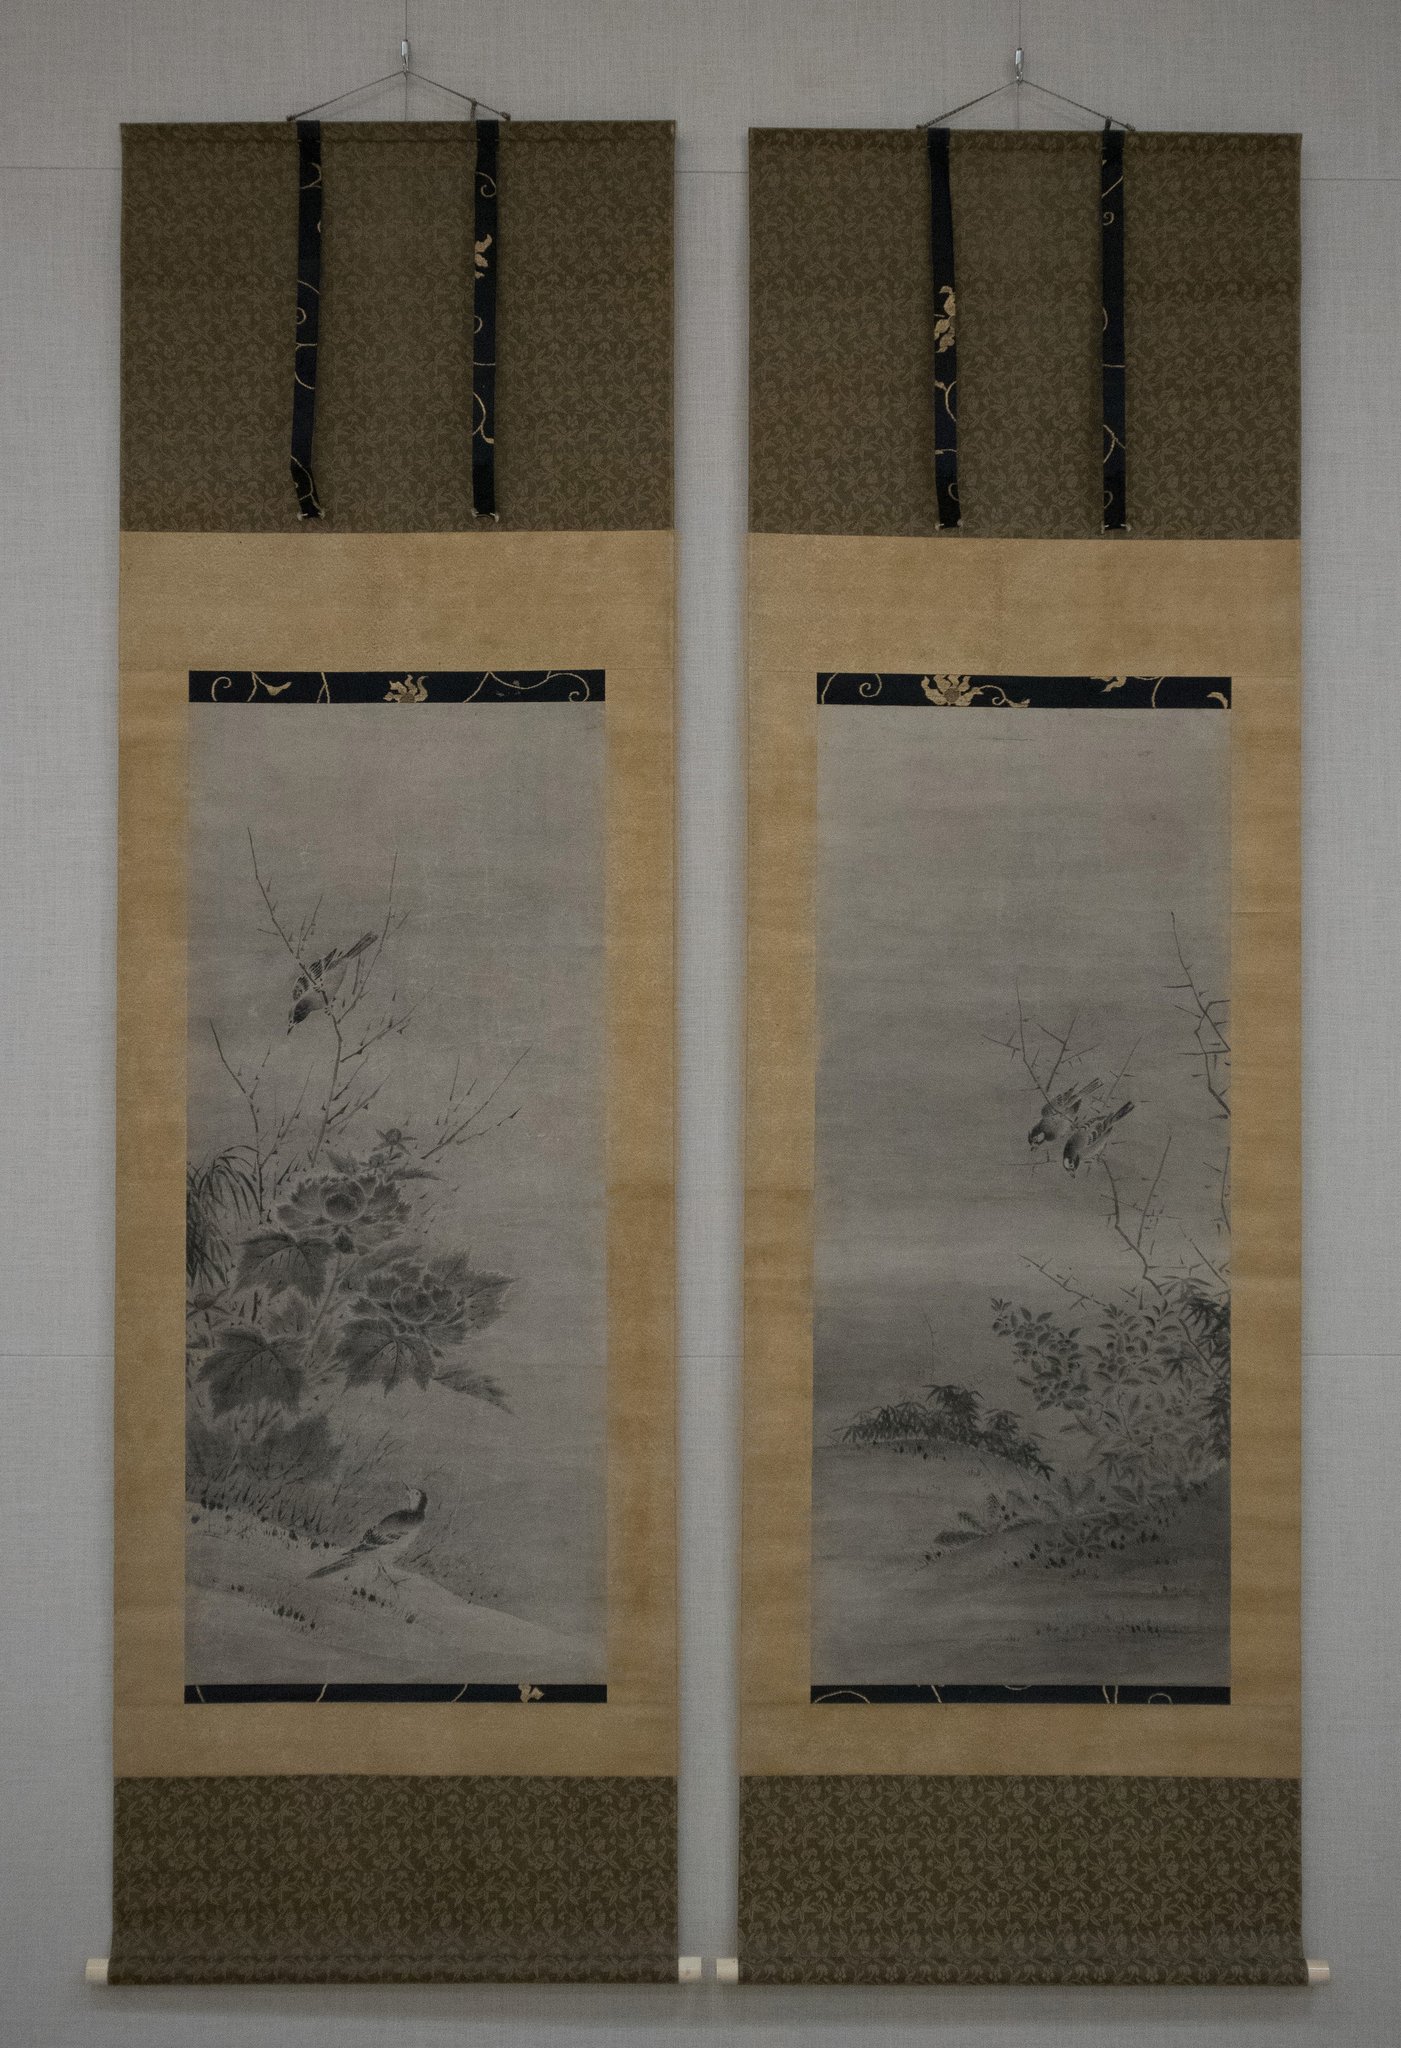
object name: hanging scroll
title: Birds and Flowers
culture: japanese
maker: kano yukinobu 狩野之信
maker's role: artist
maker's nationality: japanese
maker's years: 1513-1575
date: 1534-1566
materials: ink, paper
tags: birds